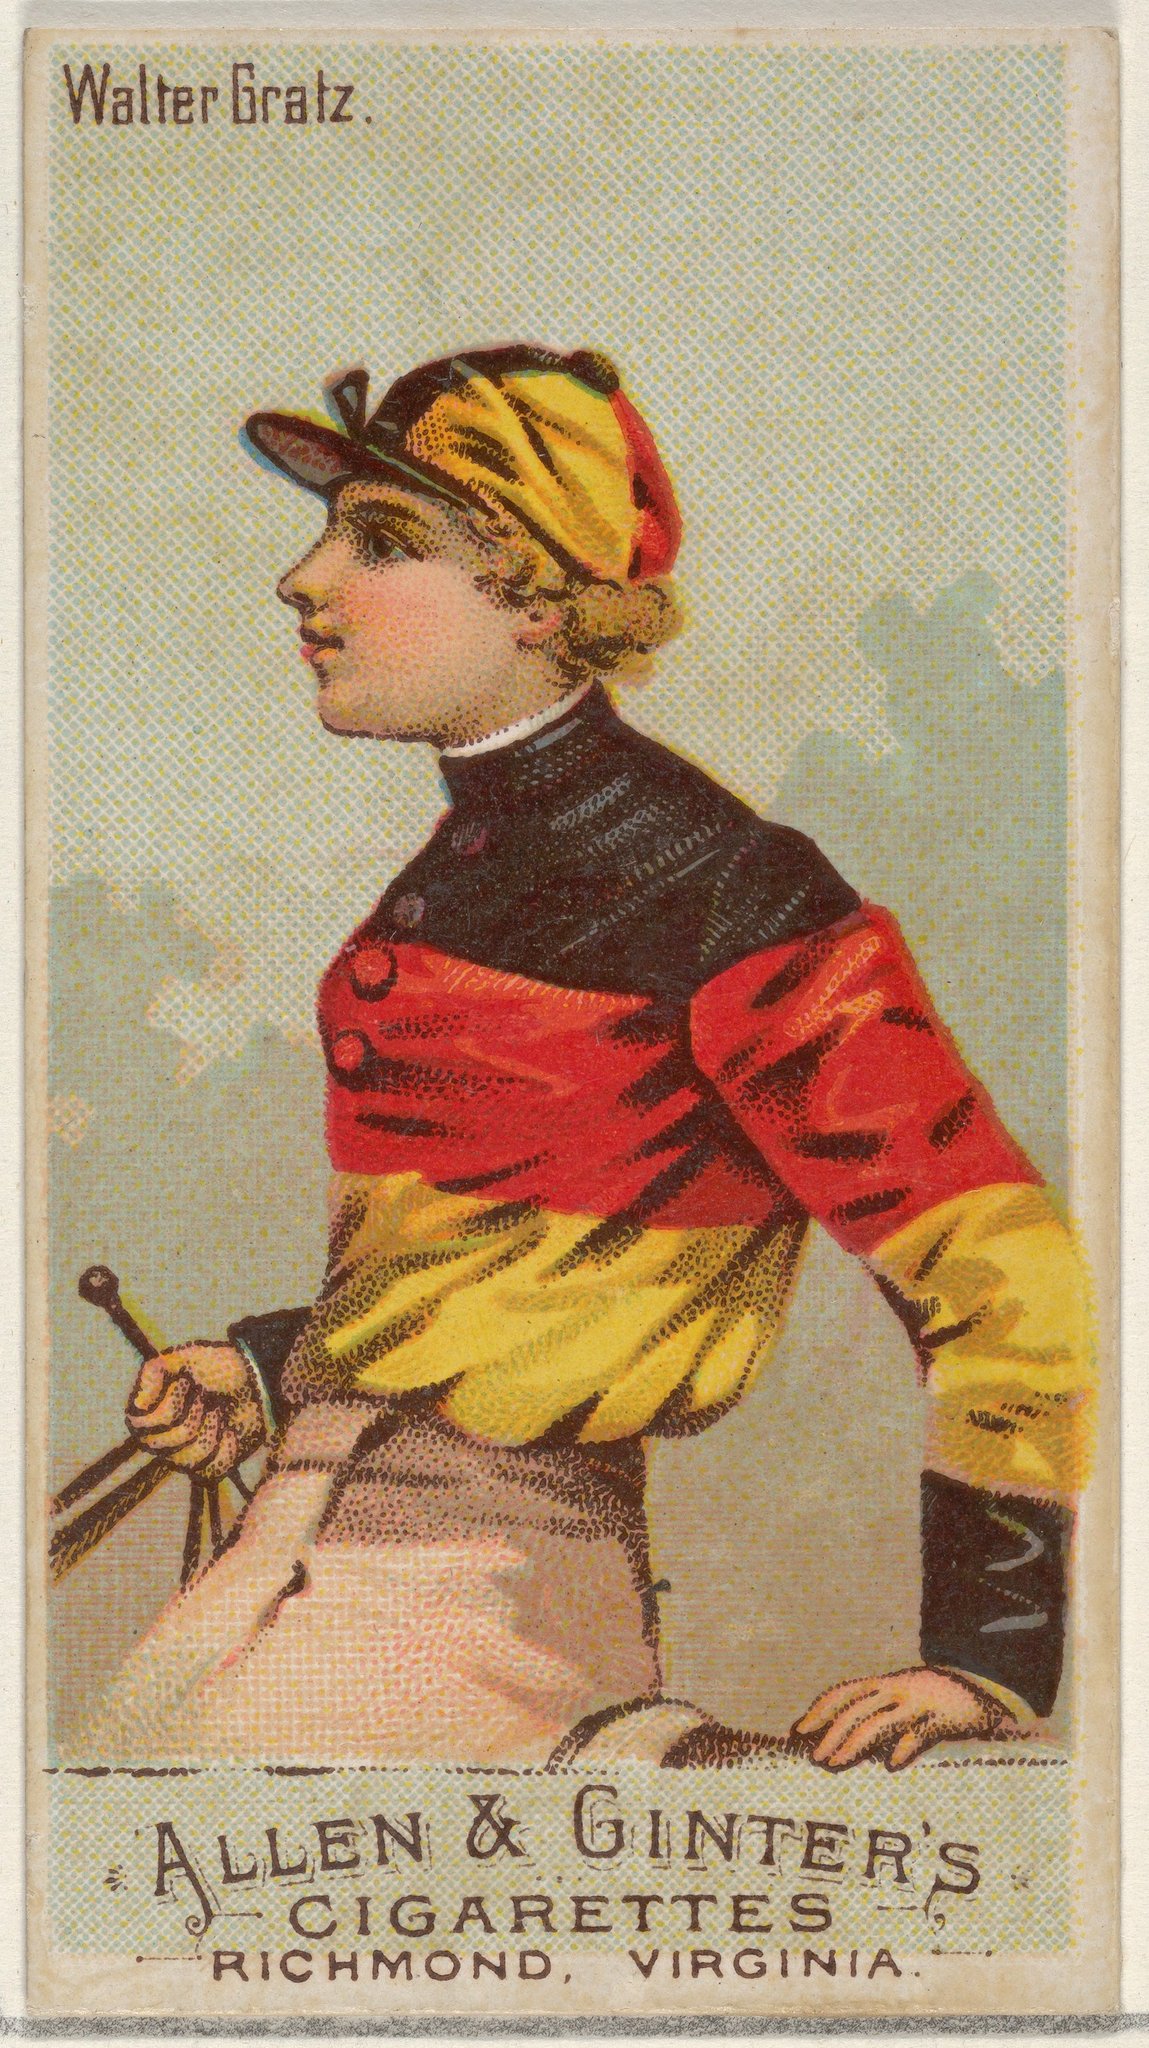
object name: print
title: Walter Gratz, from the Racing Colors of the World series (N22a) for Allen & Ginter Cigarettes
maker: allen & ginter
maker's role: publisher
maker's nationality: american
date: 1888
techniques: color lithograph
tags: men,profiles,jockeys